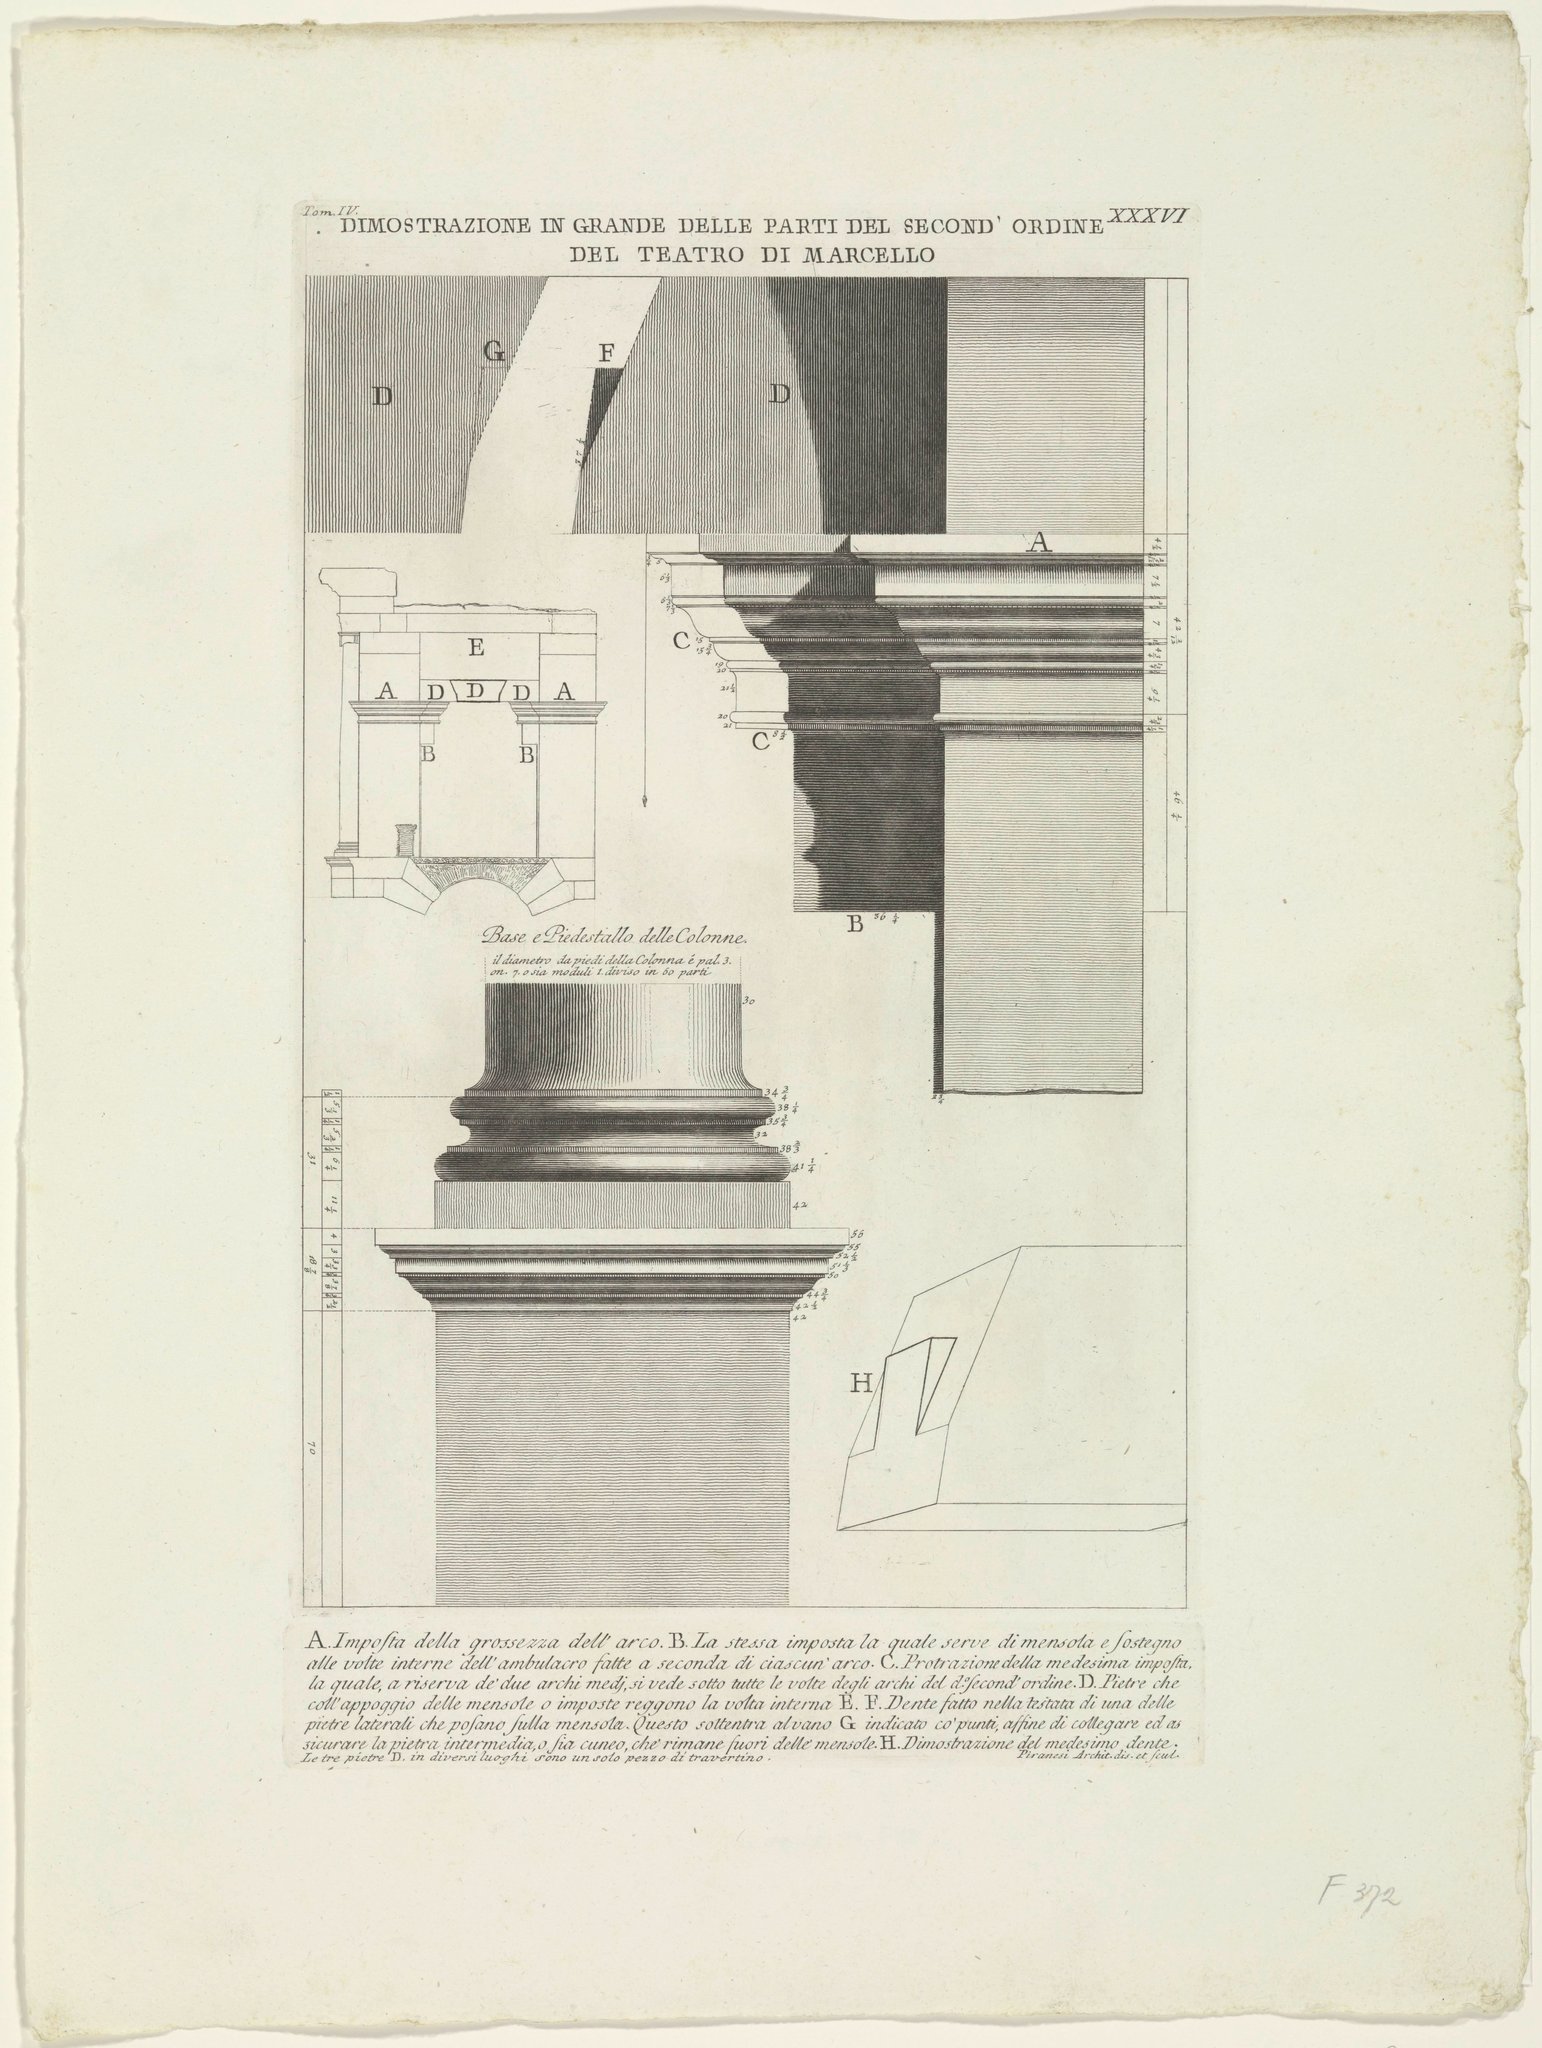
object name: print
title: Archeologische vondsten in en rond Rome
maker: giovanni battista piranesi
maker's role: designer, draughtsman, print maker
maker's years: 1720-1778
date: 1756-1757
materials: paper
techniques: etching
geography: rome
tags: theatre (building), base (~ column, pillar)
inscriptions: collector's mark: Lugt 2228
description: Deze prent maakt deel uit van de serie 'Le Antichità Romane'. Piranesi deed meer dan acht jaar voorstudie voor deze 250 platen tellende serie die in vier volumes werd uitgegeven. Hij produceerde de prenten tussen ca. 1756 en 1757. De serie bevat ook prenten door of naar andere prentmakers, onder wie Francesco Bianchini en Girolamo Rossi.